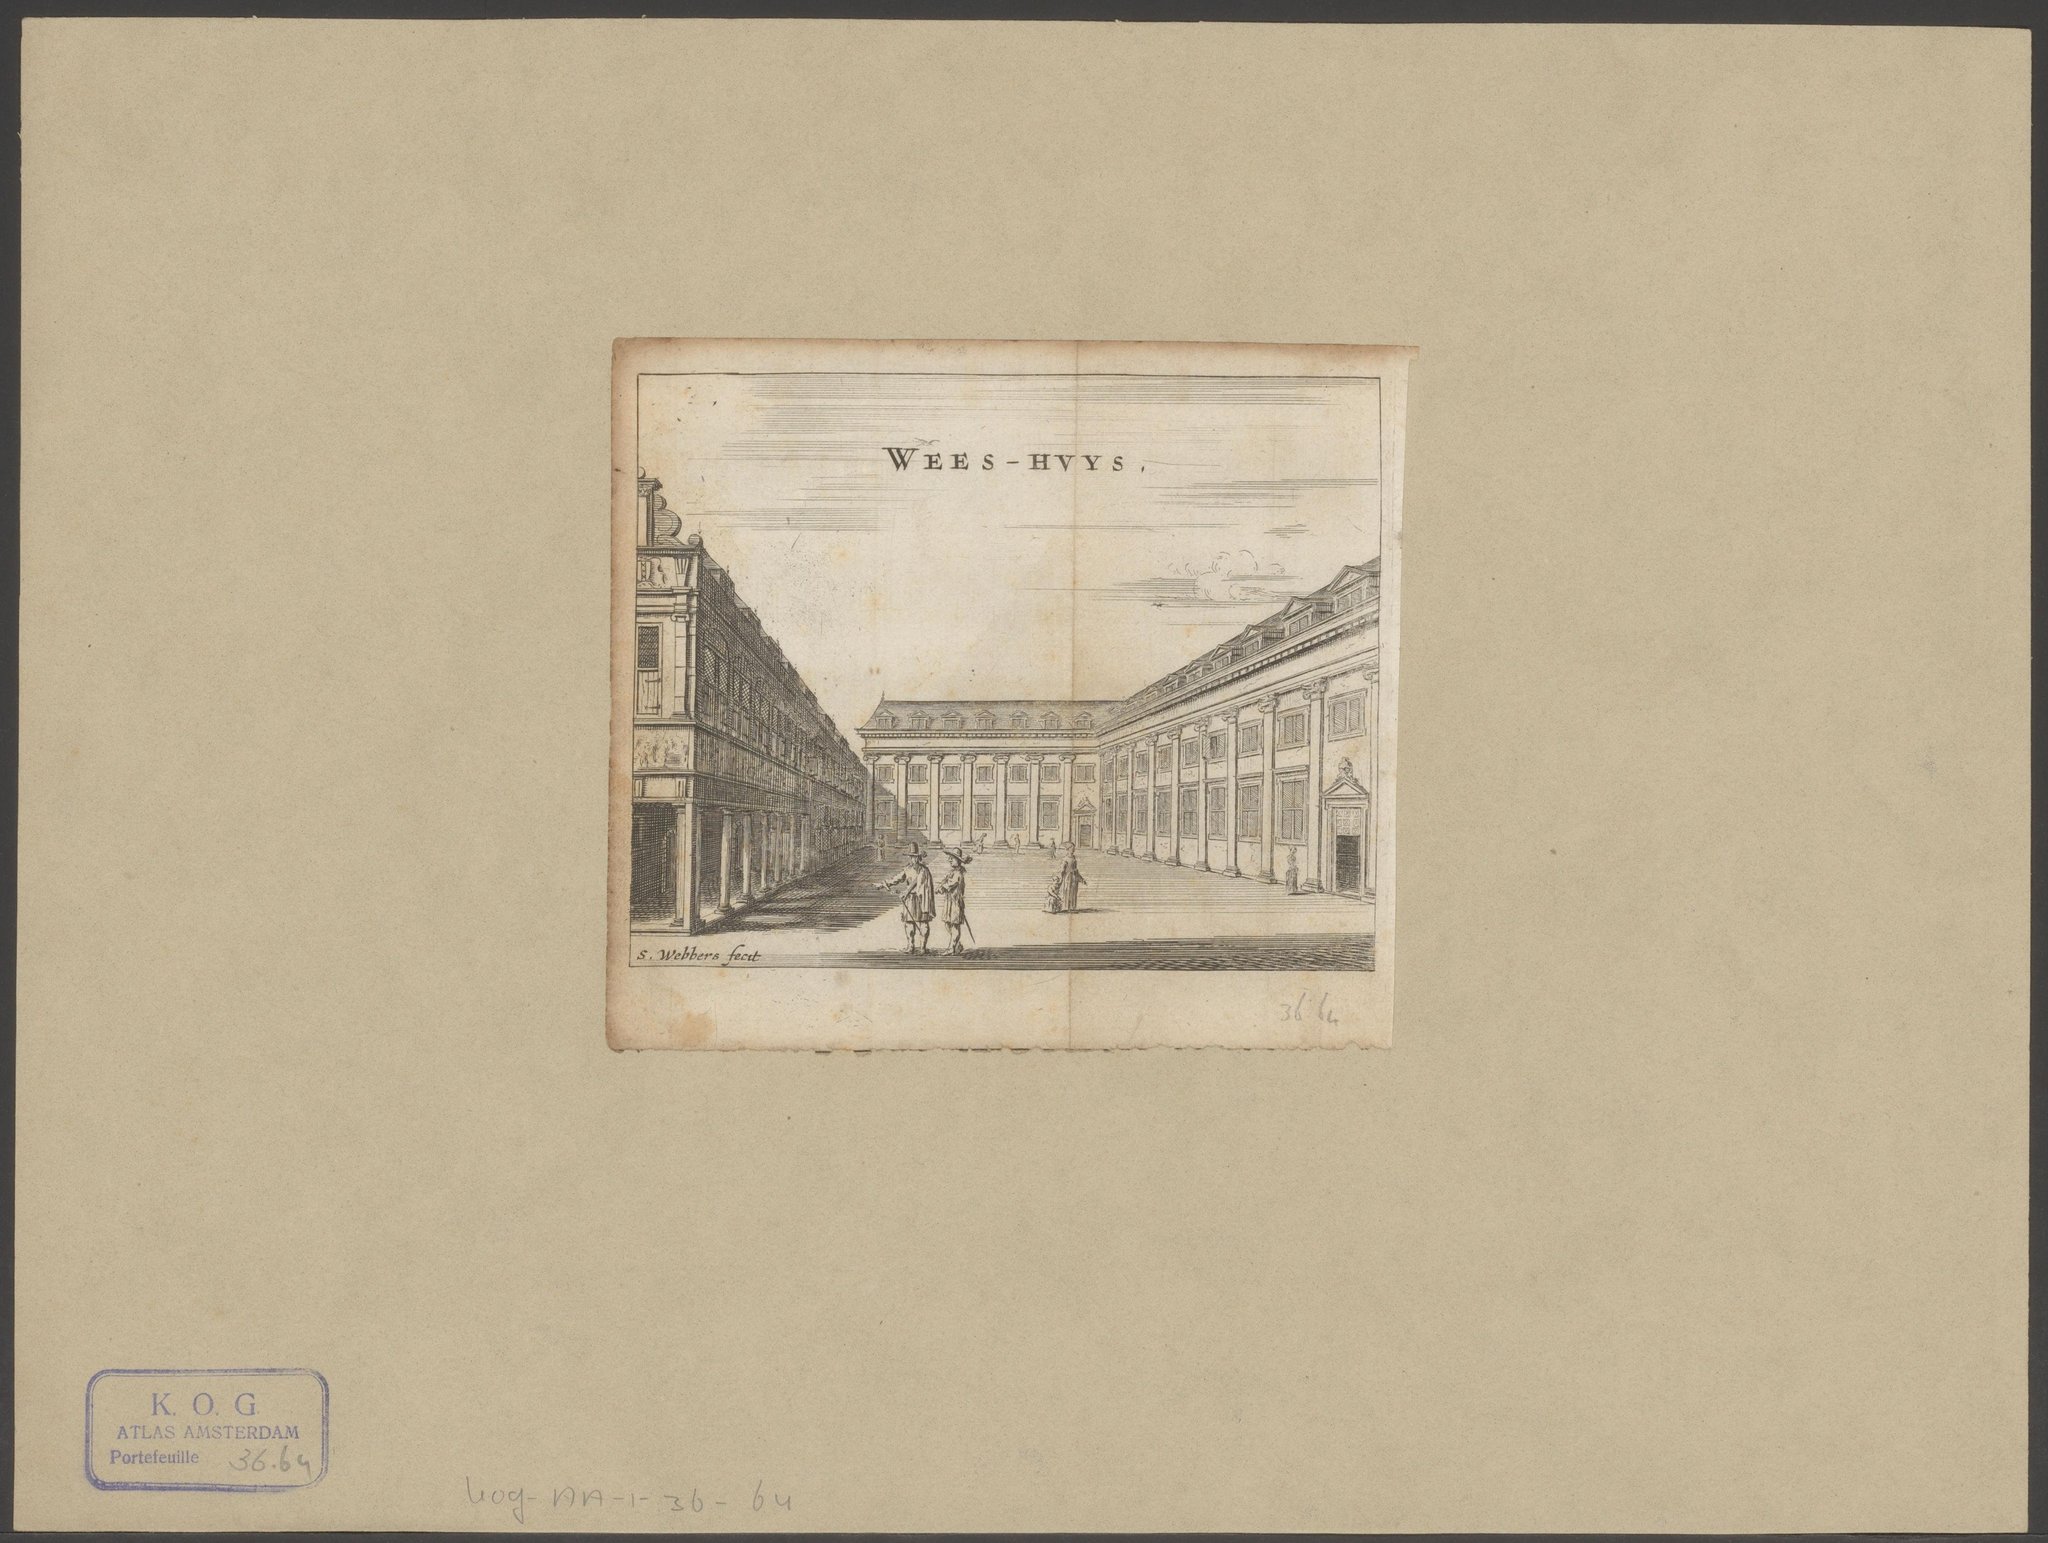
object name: print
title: Gezicht op de binnenplaats van het Burgerweeshuis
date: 1664-1665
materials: paper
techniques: etching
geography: amsterdam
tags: public welfare, courtyard, orphanage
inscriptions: collector's mark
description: Onderwerpsrubriek binnen de Atlas Amsterdam: Armwezen en liefdadige instellingen: I. Stadsinrichtingen: Burgerweeshuis.